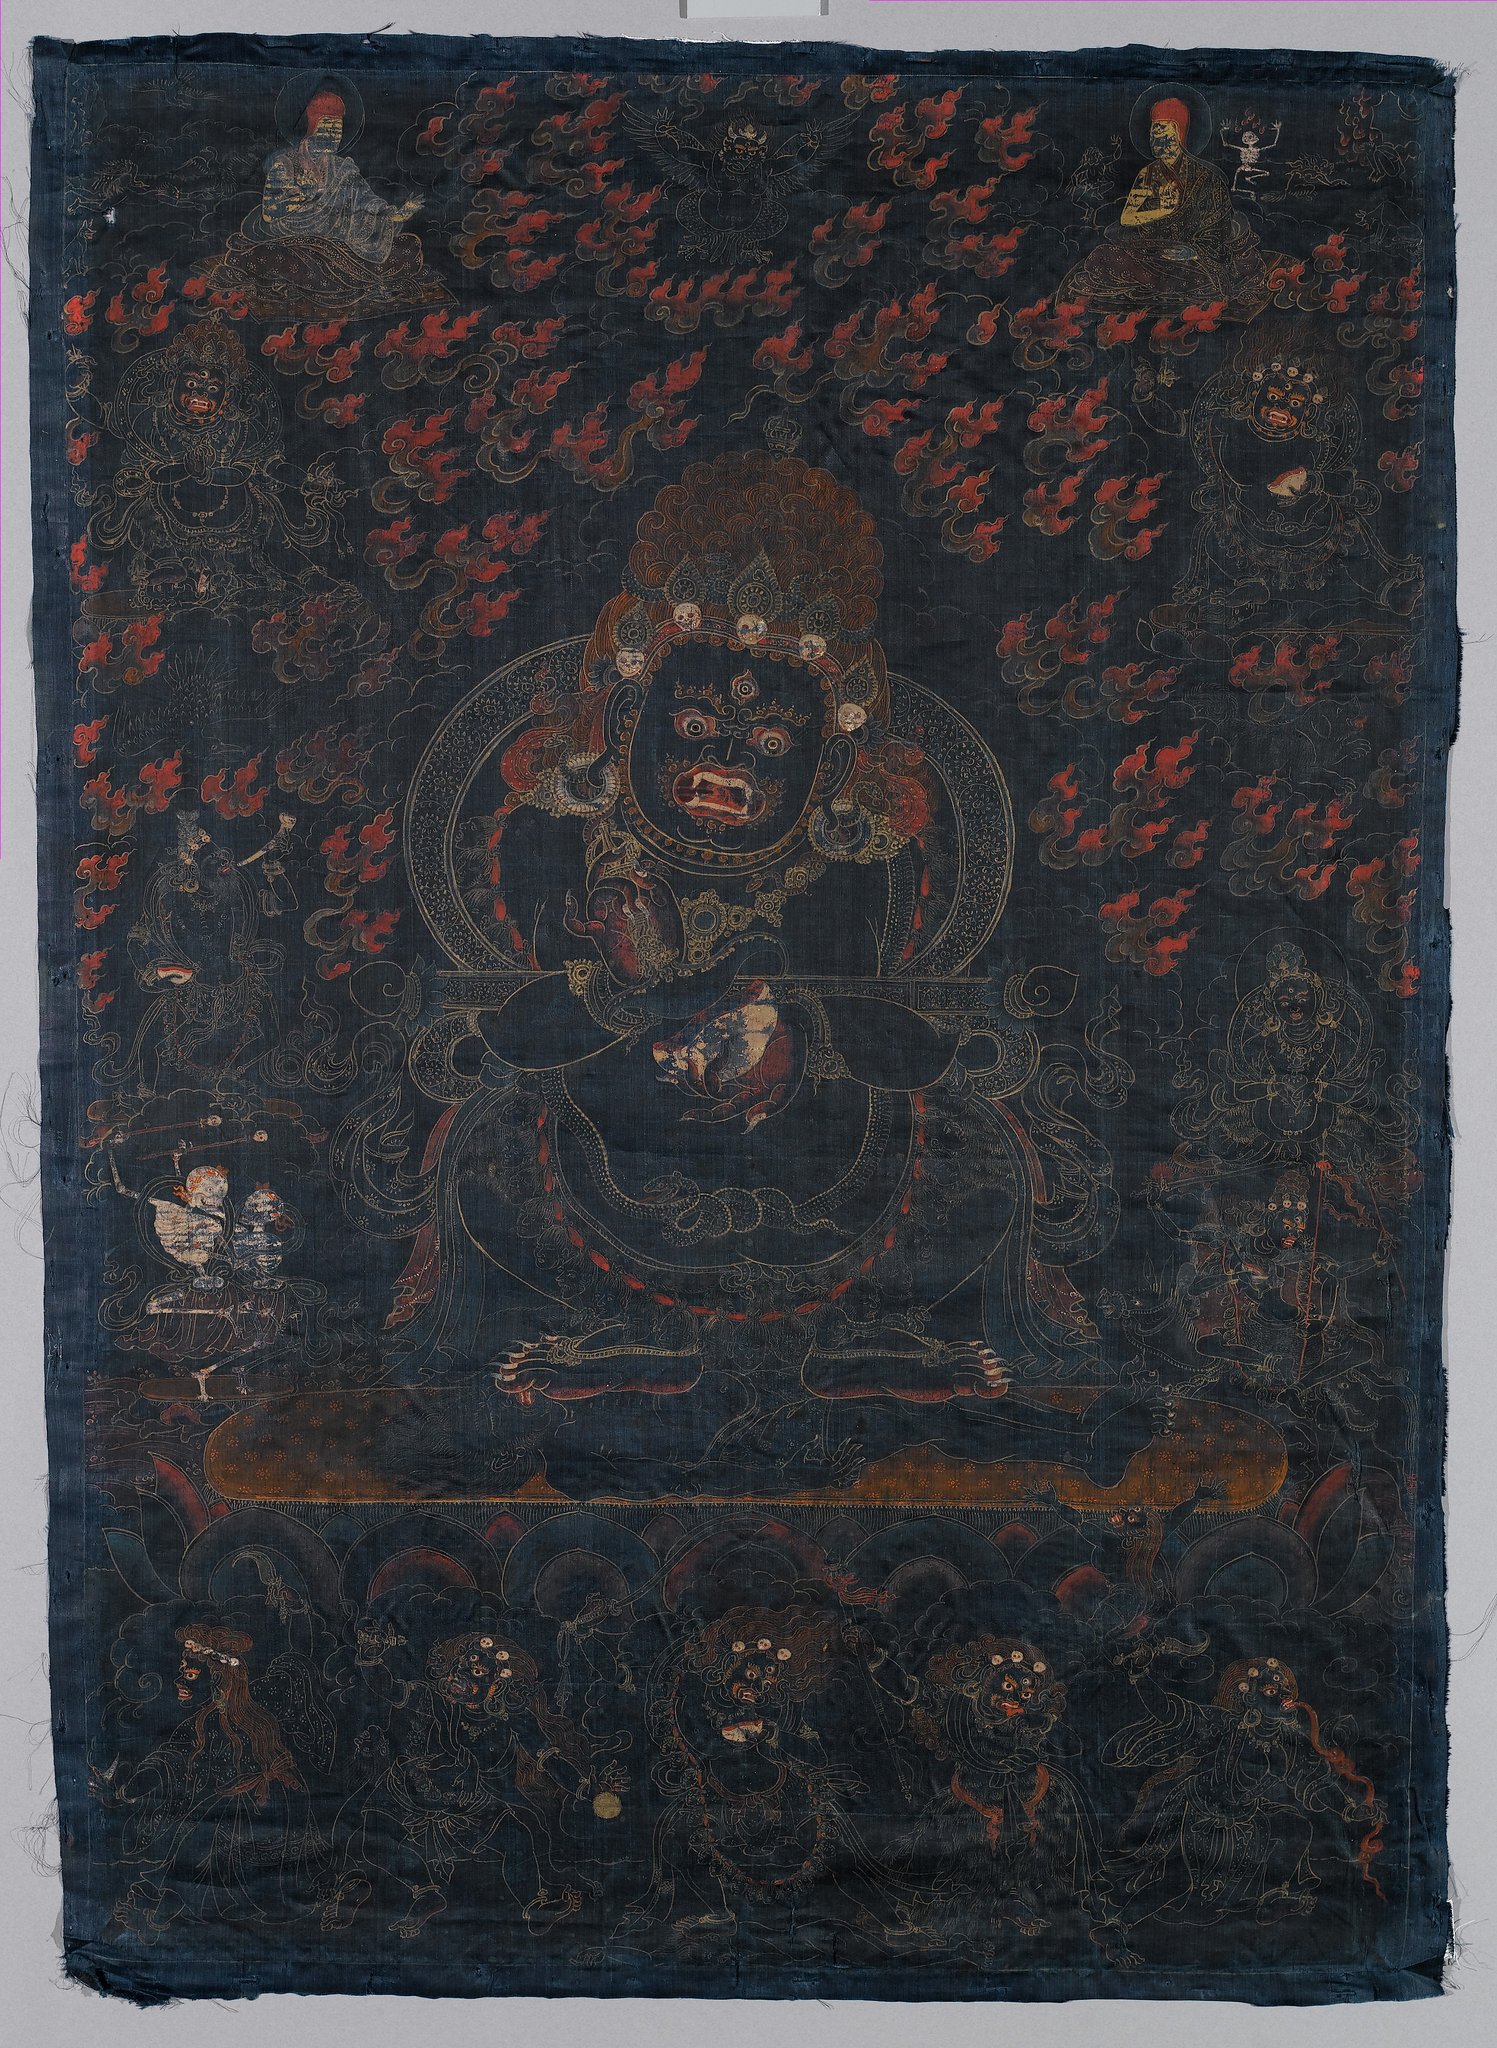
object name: thangka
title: Mahakala, Protector of the Tent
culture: tibetan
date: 1650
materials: gold, silk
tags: skeletons,buddhism,deities